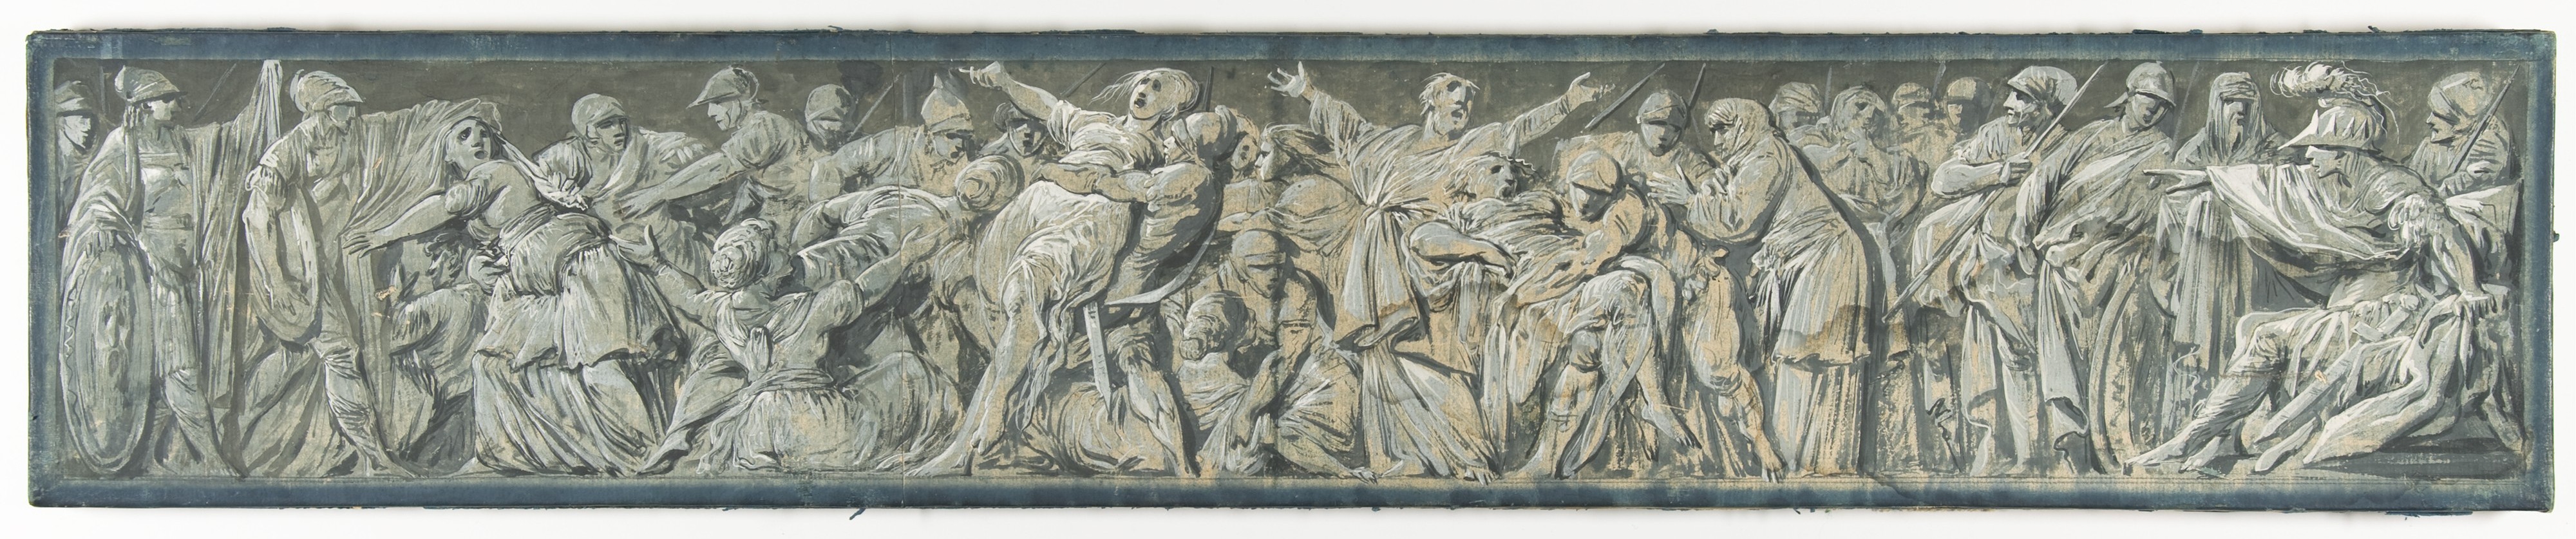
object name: drawing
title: The Rape of the Sabines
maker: jacques gamelin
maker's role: artist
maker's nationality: french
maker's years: 1738-1803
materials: gouache, graphite, paper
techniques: brush, heightening, wash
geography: france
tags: men,women